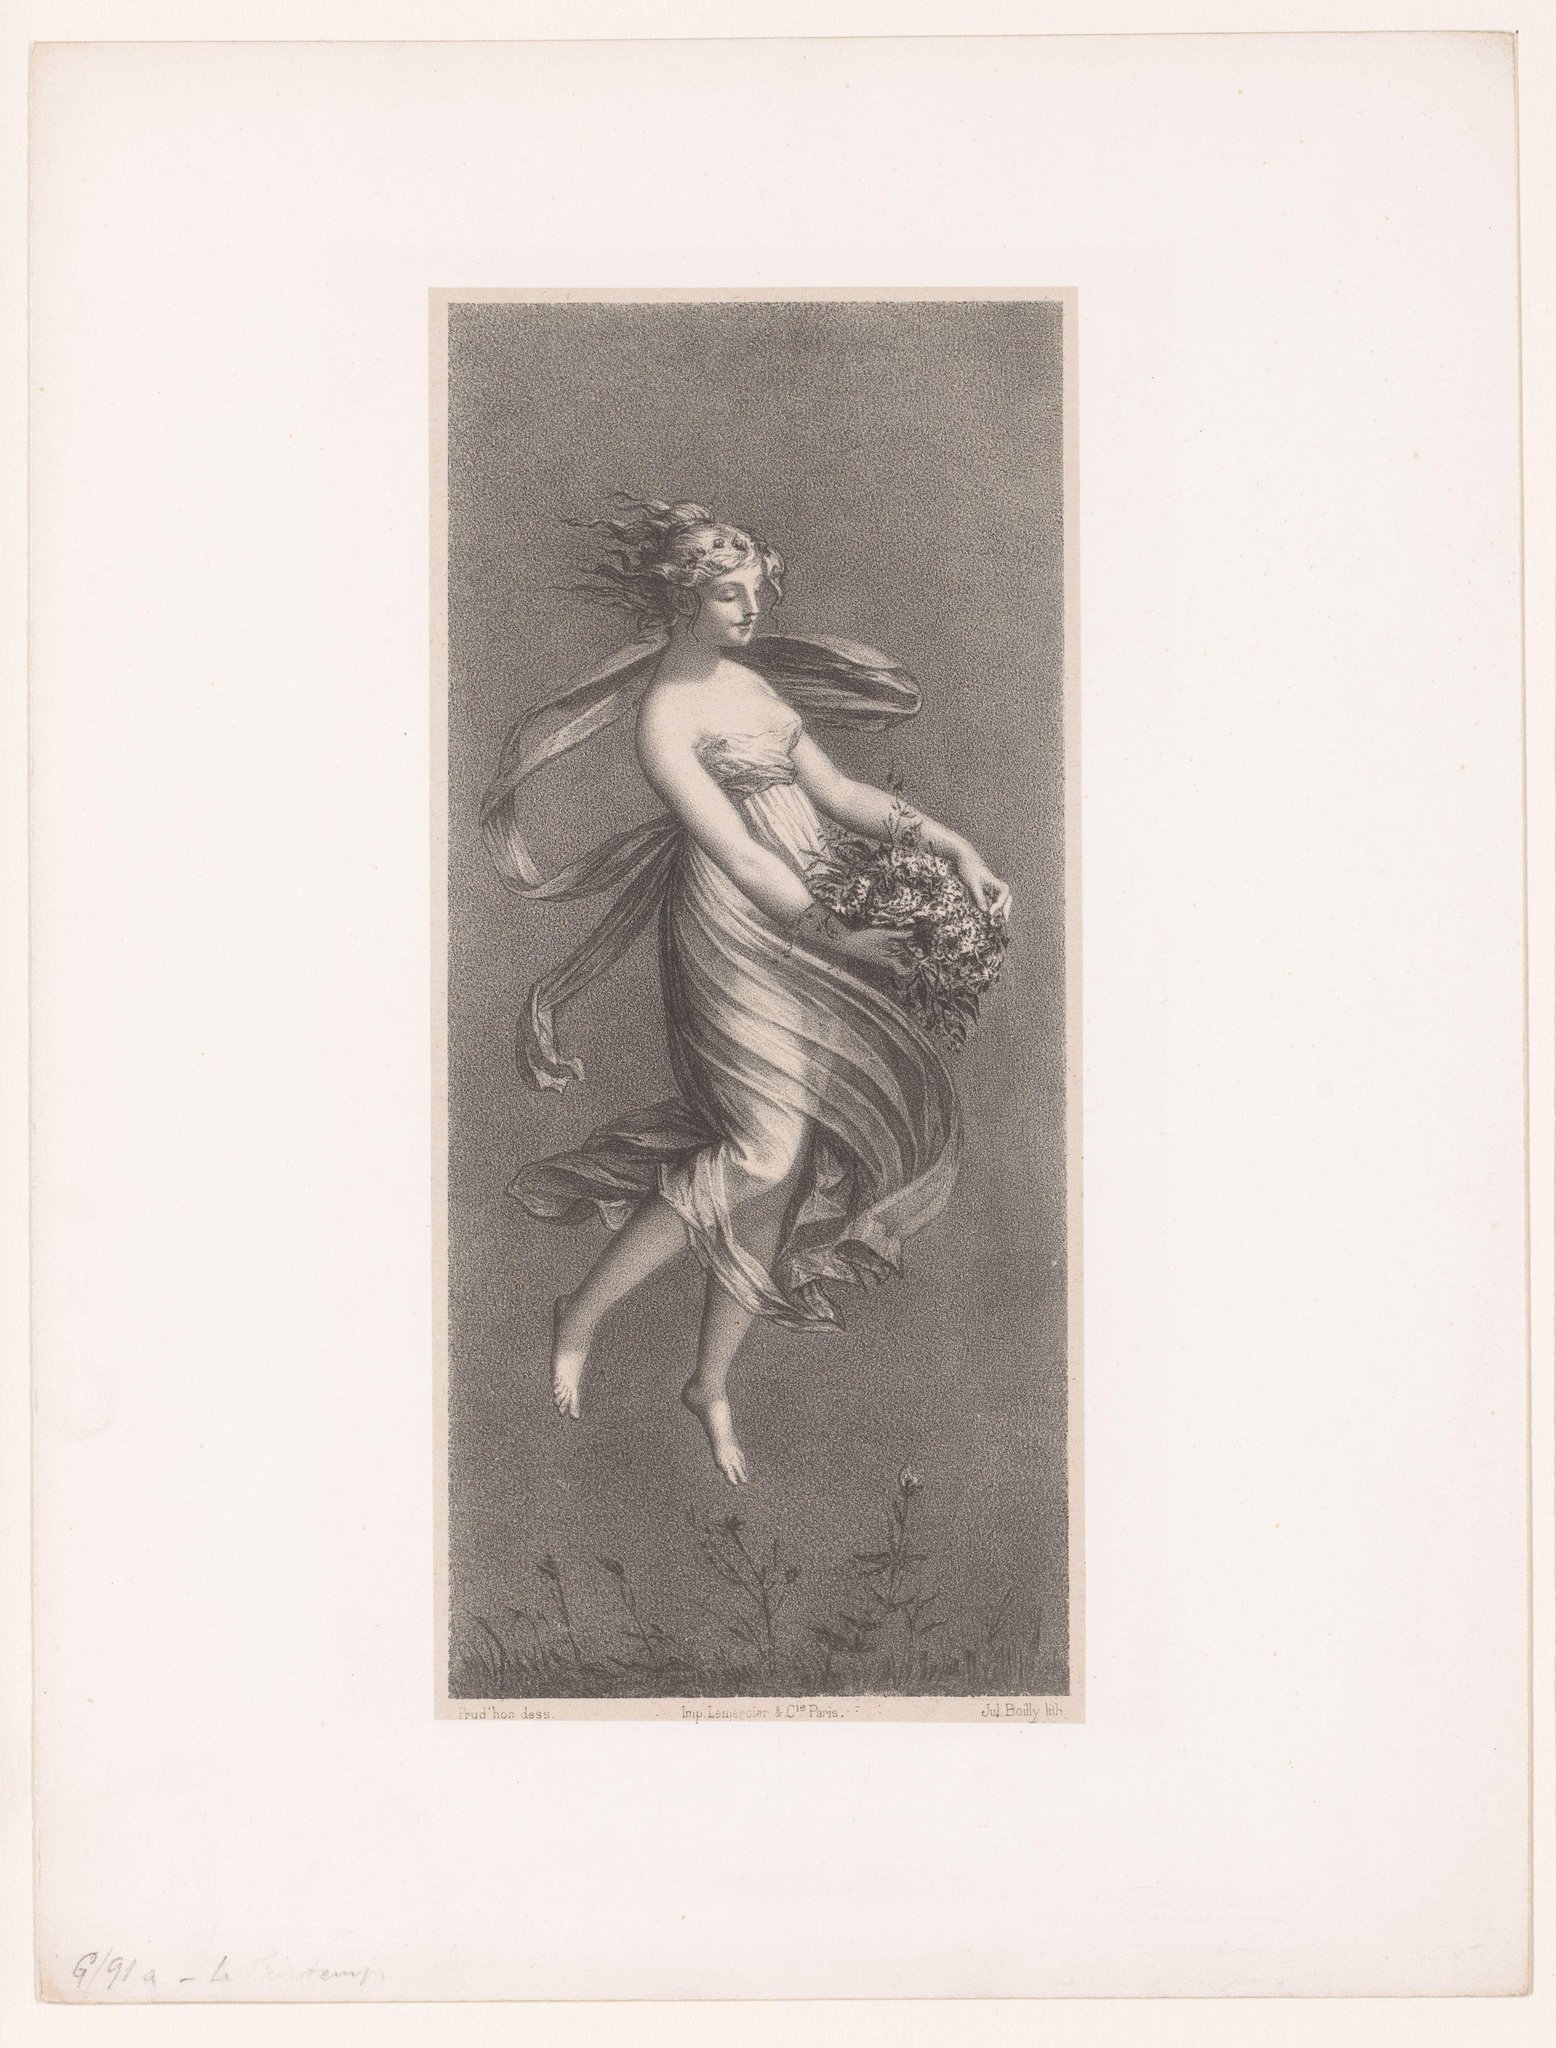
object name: print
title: Vier seizoenen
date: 1811-1867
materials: paper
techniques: lithograph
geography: paris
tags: spring, 'ver'; 'primavera' (ripa)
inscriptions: collector's mark: Lugt 2760, collector's mark: Lugt 2228